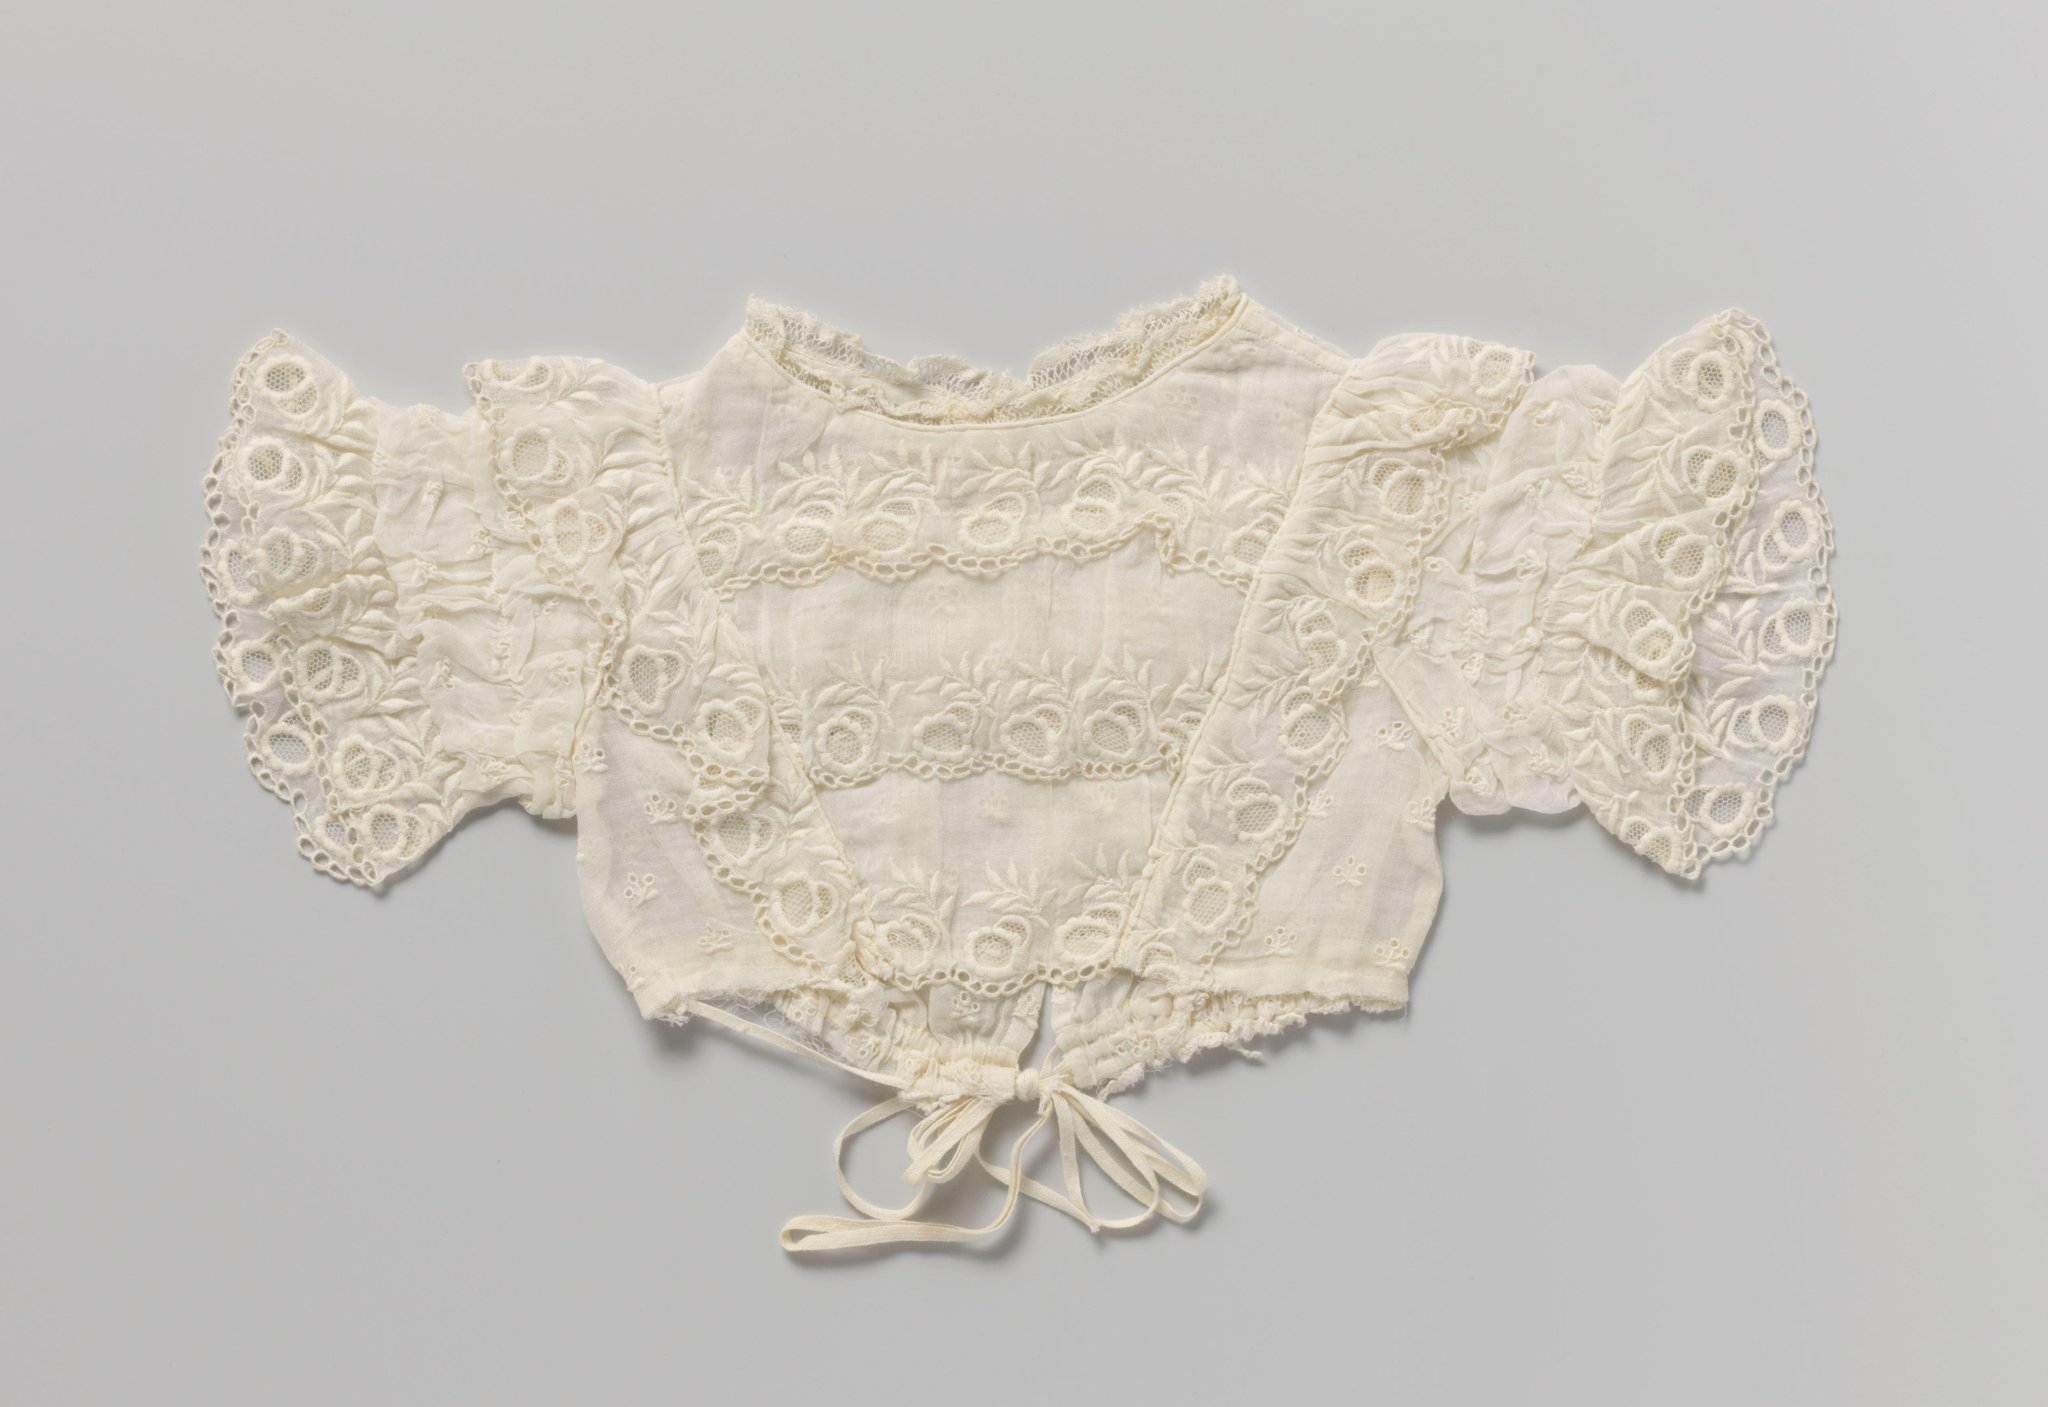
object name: girls' wear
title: Lijfje van een Empire-kinderjurk "lange jurk"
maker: Anonymous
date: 1815-1820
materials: textile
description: Een lijfje van een Empire-kinderjurk "lange jurk".